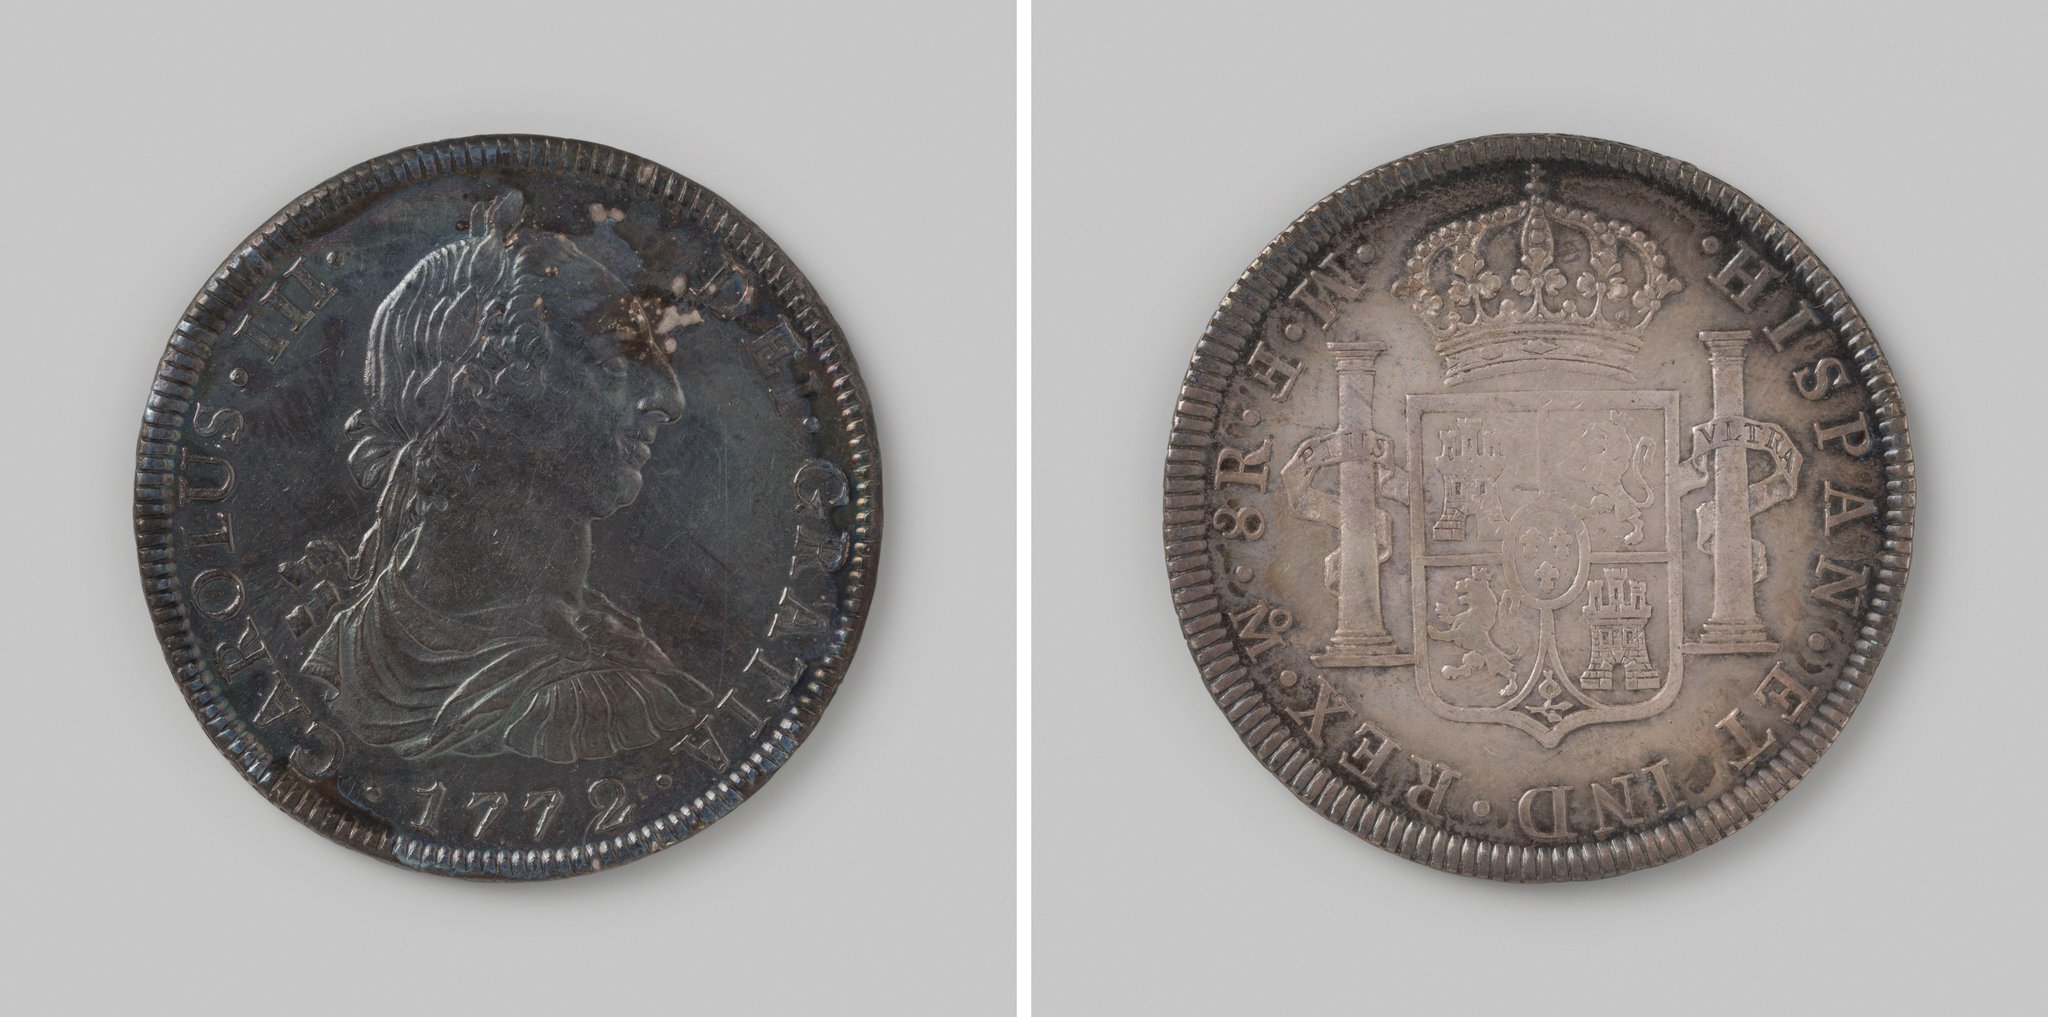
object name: coin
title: Peso of acht reaal uit Mexico van koning Karel III,1772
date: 1772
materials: silver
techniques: striking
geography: mexico city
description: Zilveren munt. Voorzijde: gelauwerd hoofd van de koning naar rechts. Jaartal onderaan. Keerzijde: tussen twee uit zee oprijzende zuilen, waarop banderol met opschrift, gekroond samengesteld wapenschild. Muntplaats-aanduiding: Mo. en waarde-aanduiding: 8R in omschrift. Versierde rand.